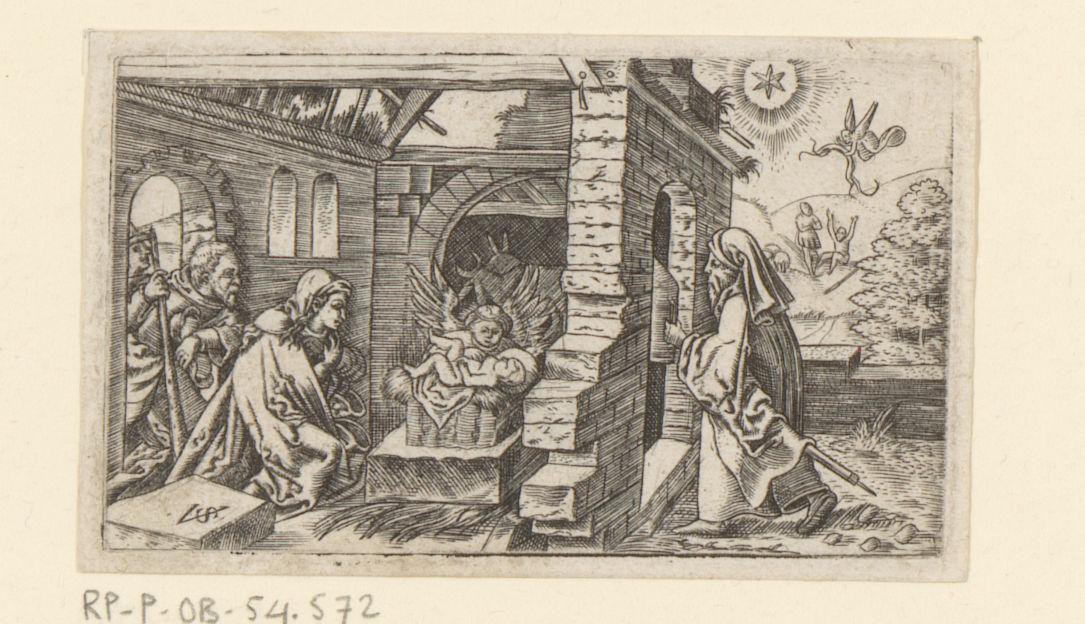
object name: print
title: Aanbidding door de herders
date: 1524-1612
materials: paper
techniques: engraving, etching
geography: nuremberg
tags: adoration of the christ-child by the shepherds; mary and joseph present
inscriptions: collector's mark: Lugt 2228